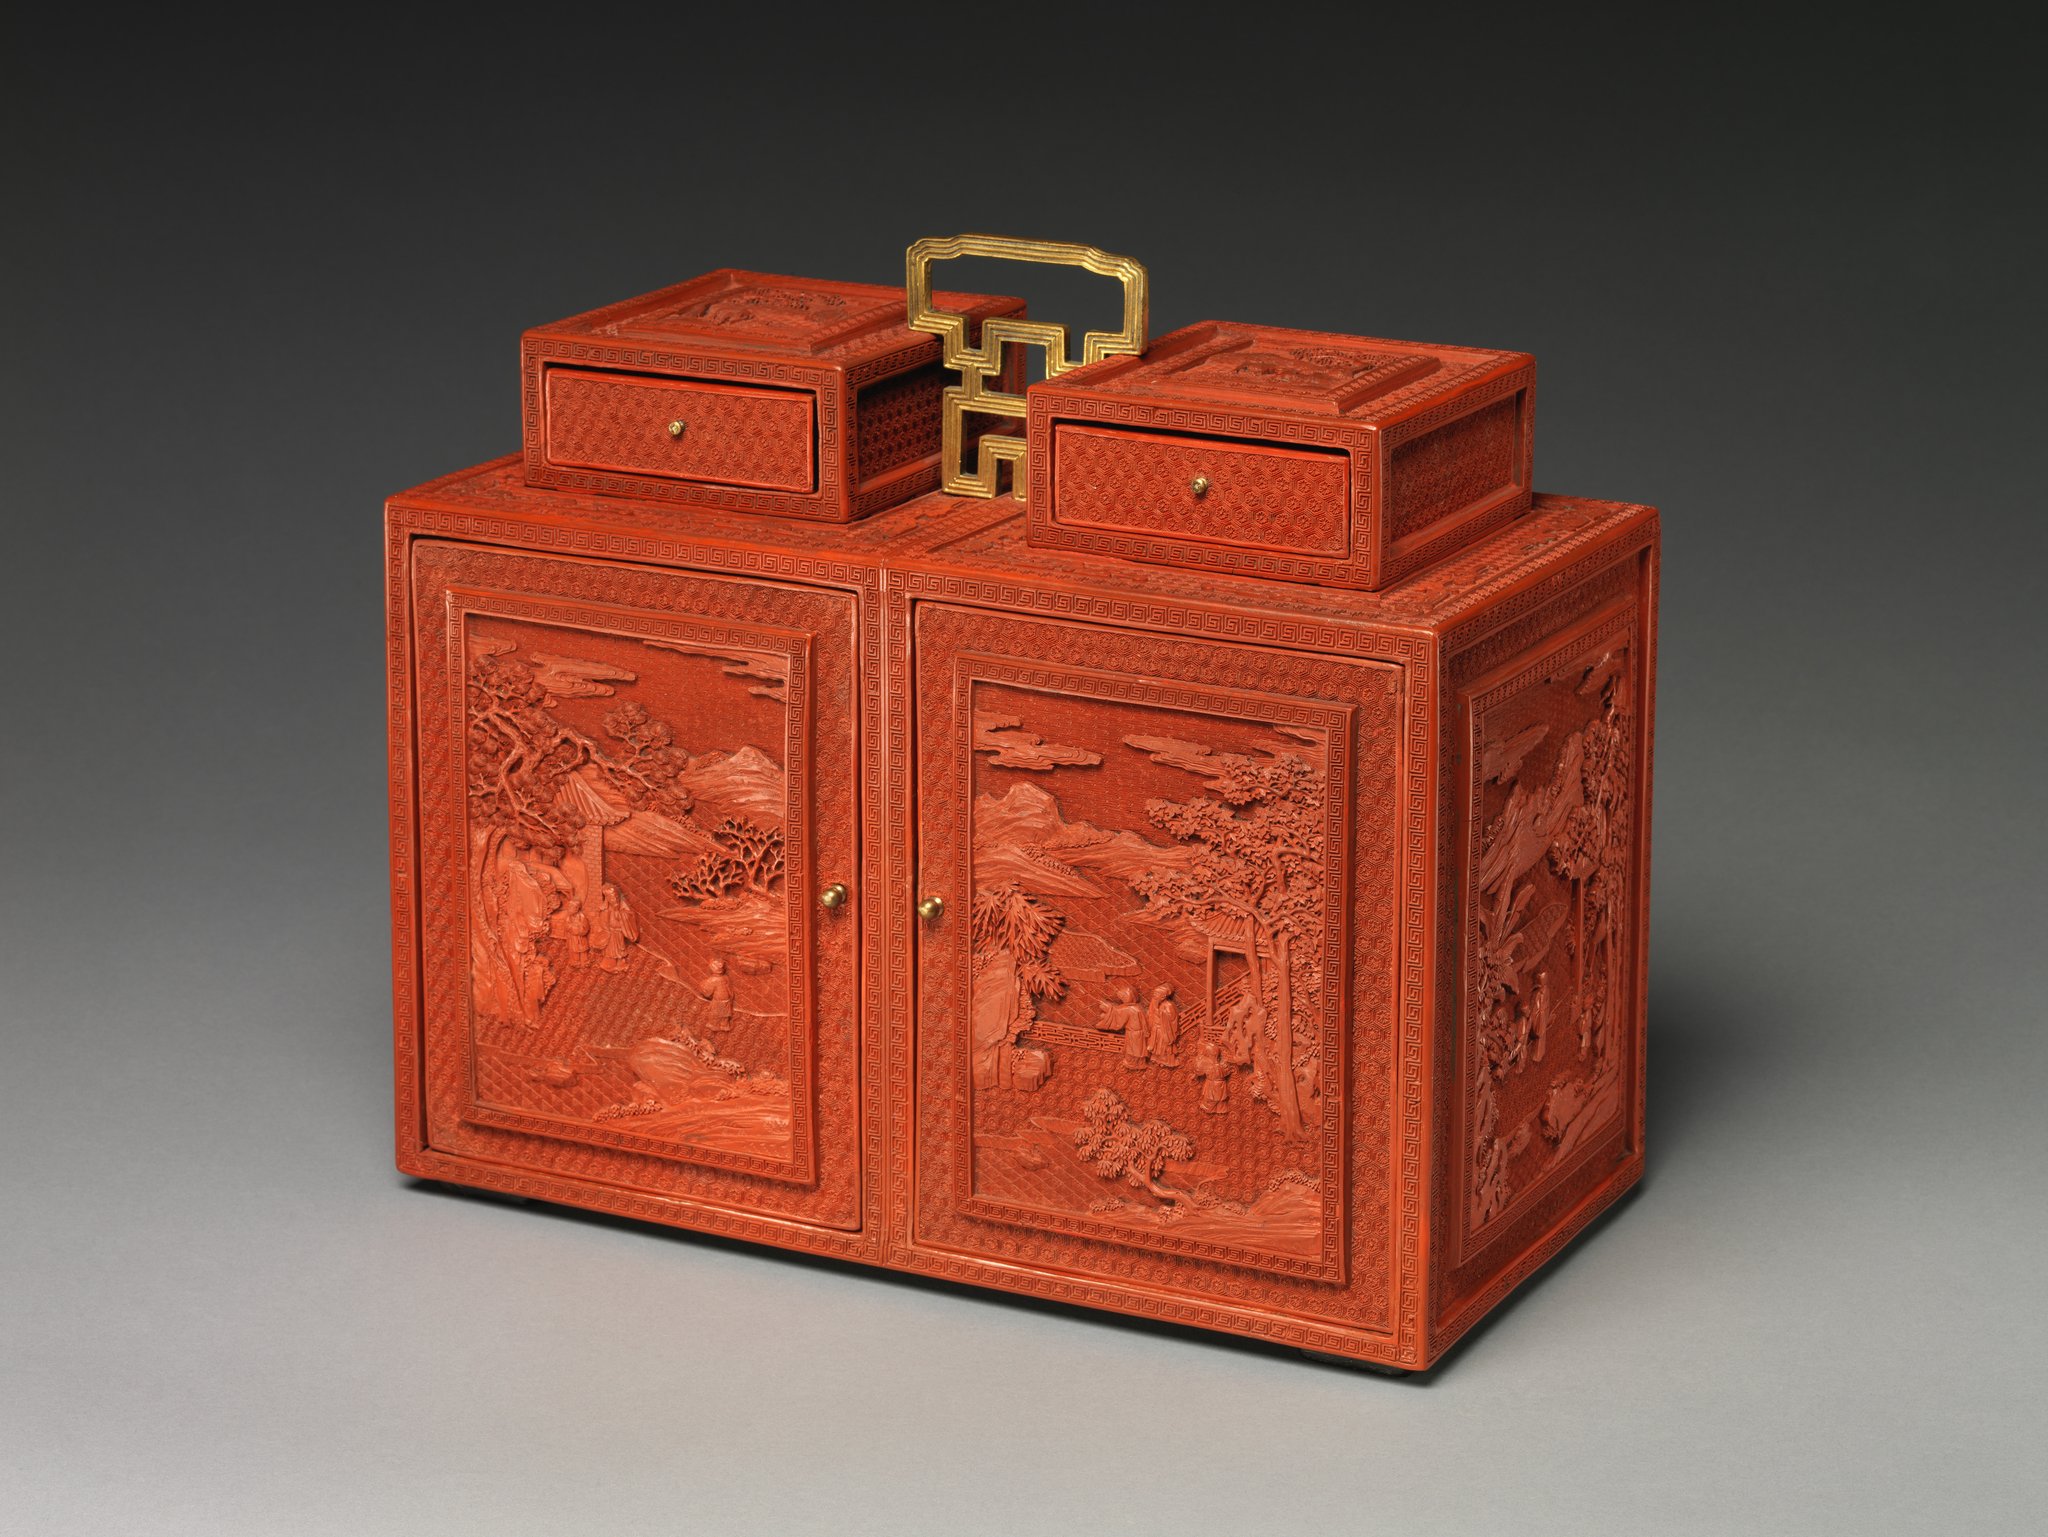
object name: cabinet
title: Cabinet with figures in a landscape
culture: chinese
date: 1701-1800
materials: gilt bronze, lacquer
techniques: carving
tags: men,mountains,trees,cabinets